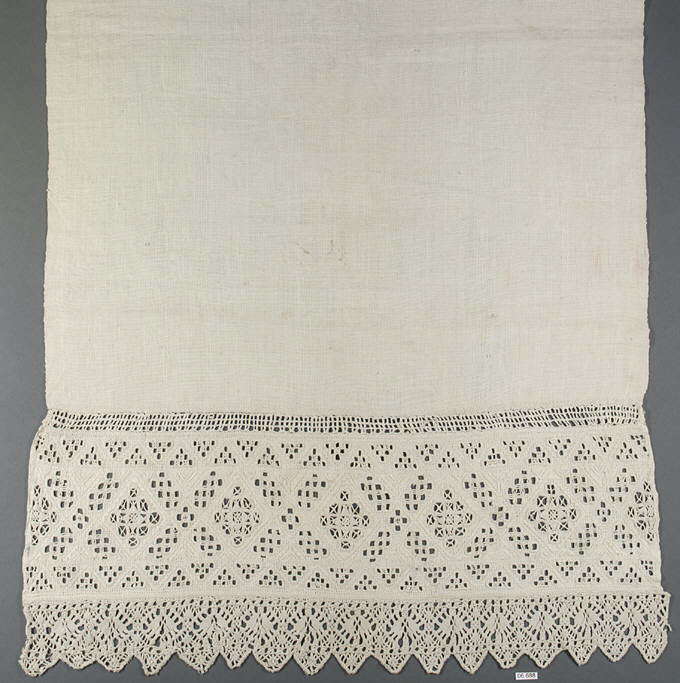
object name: towel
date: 1501-1600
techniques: lace, embroidery